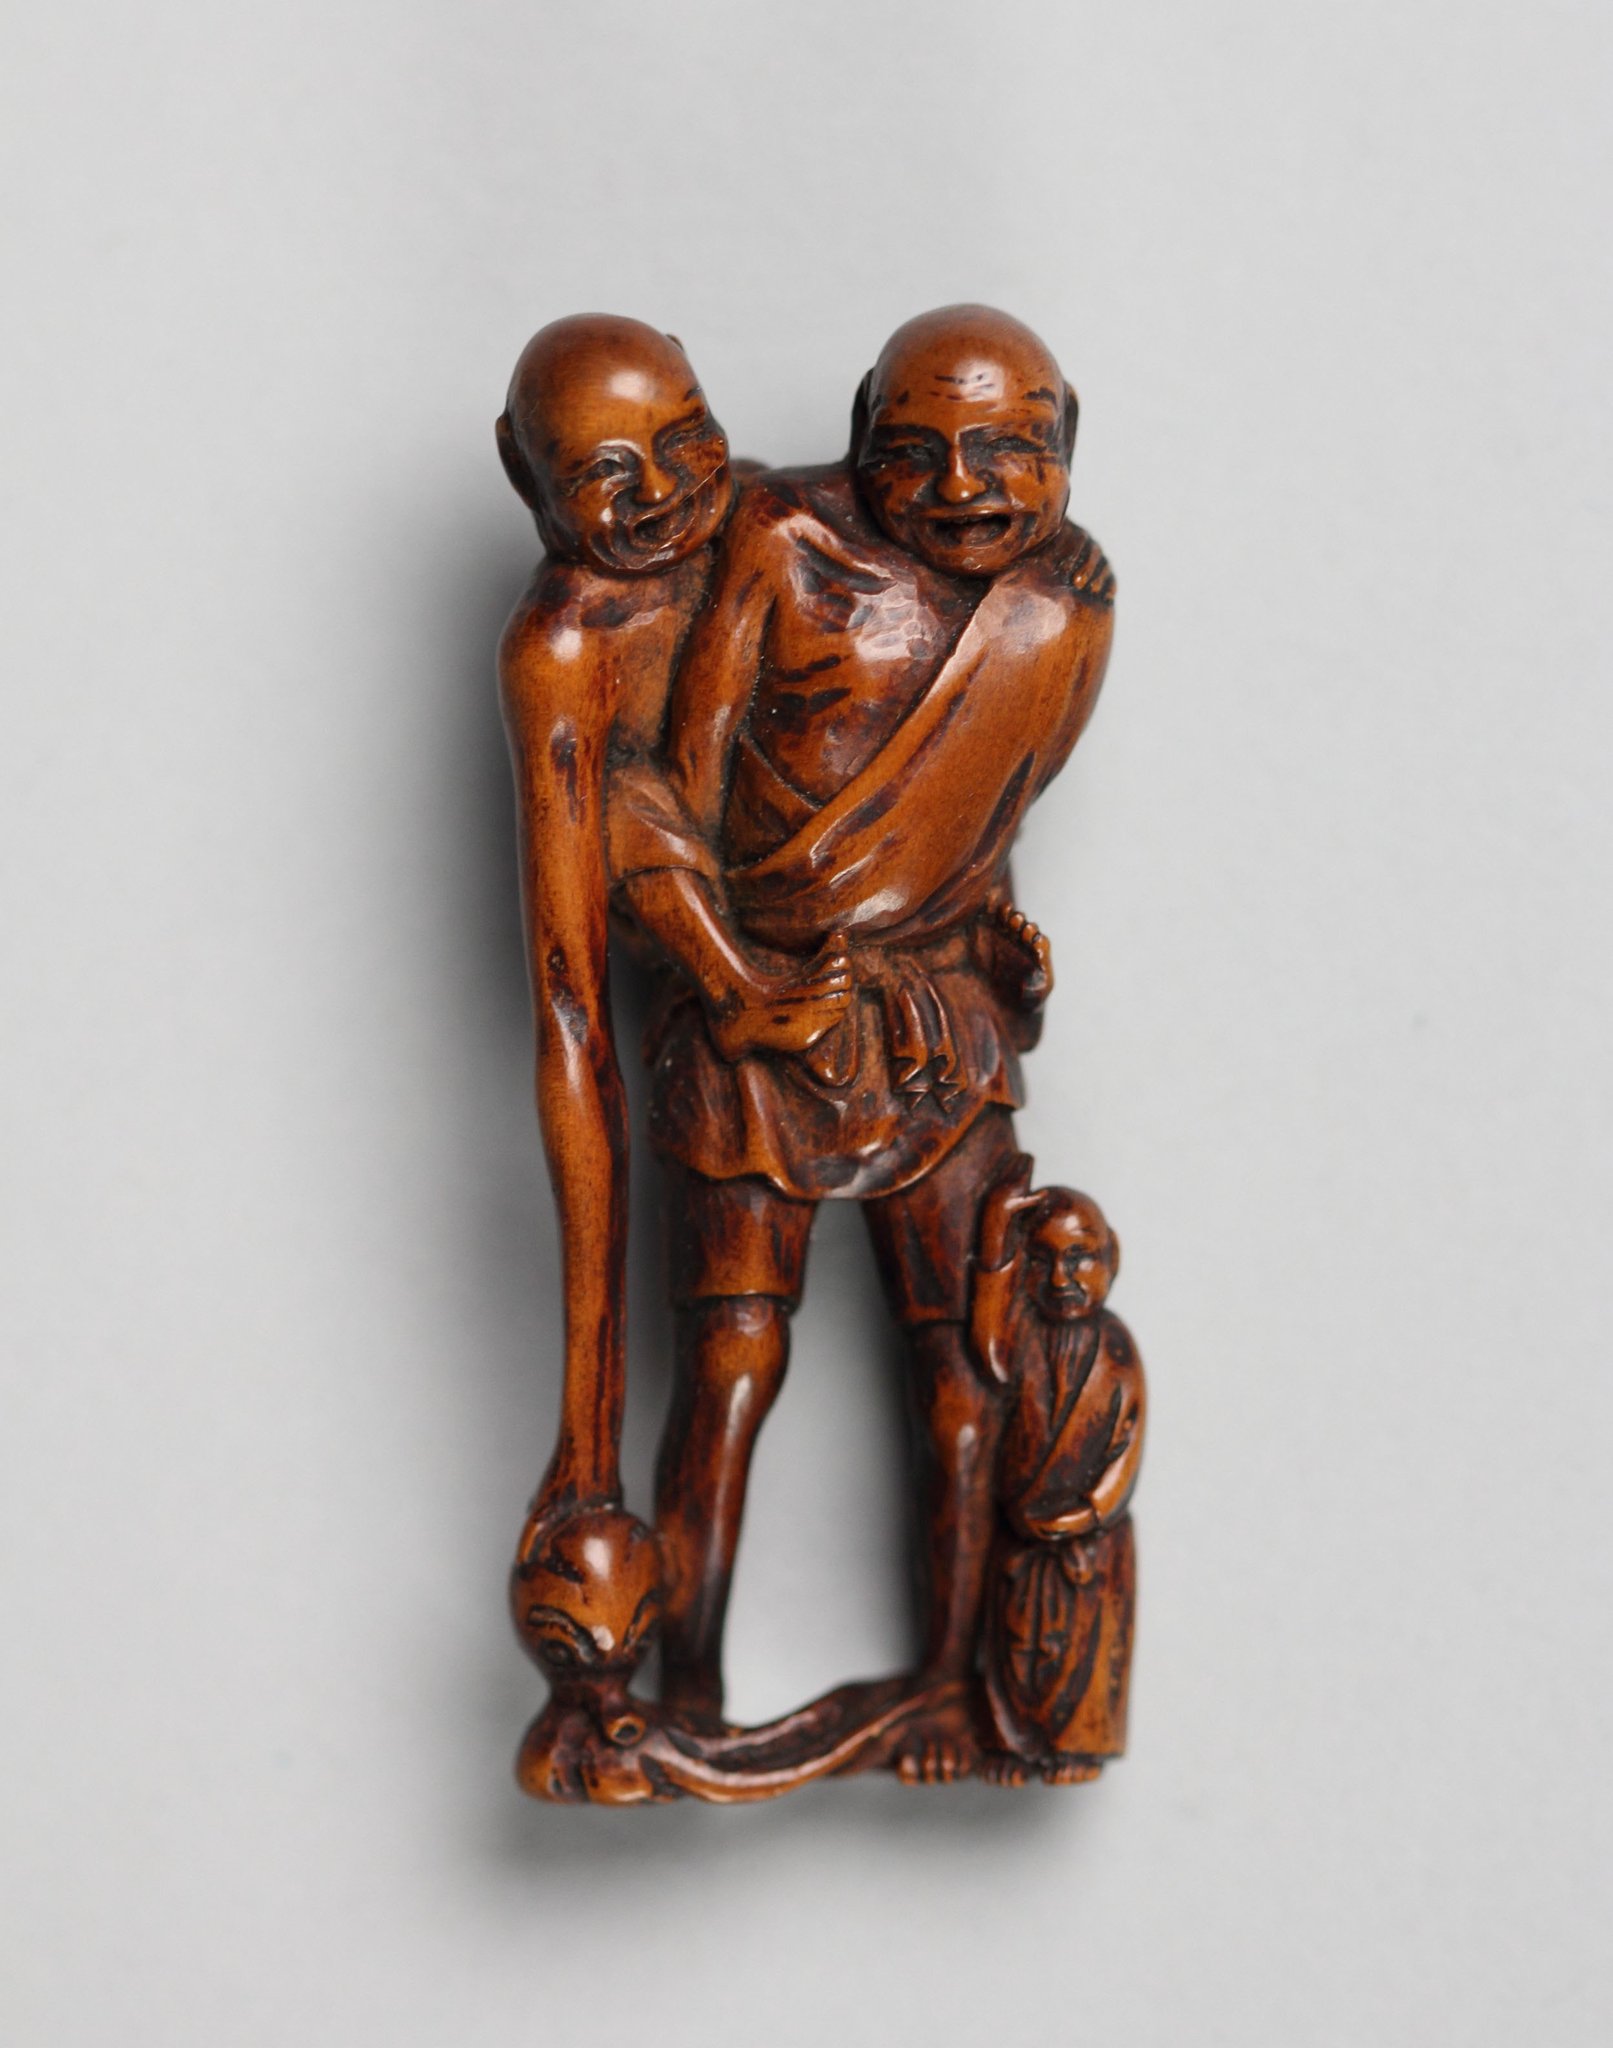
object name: netsuke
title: Netsuke: Ashinaga and Tenaga with a Child and an Octopus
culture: japanese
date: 1701-1800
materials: wood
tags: animals,children,men